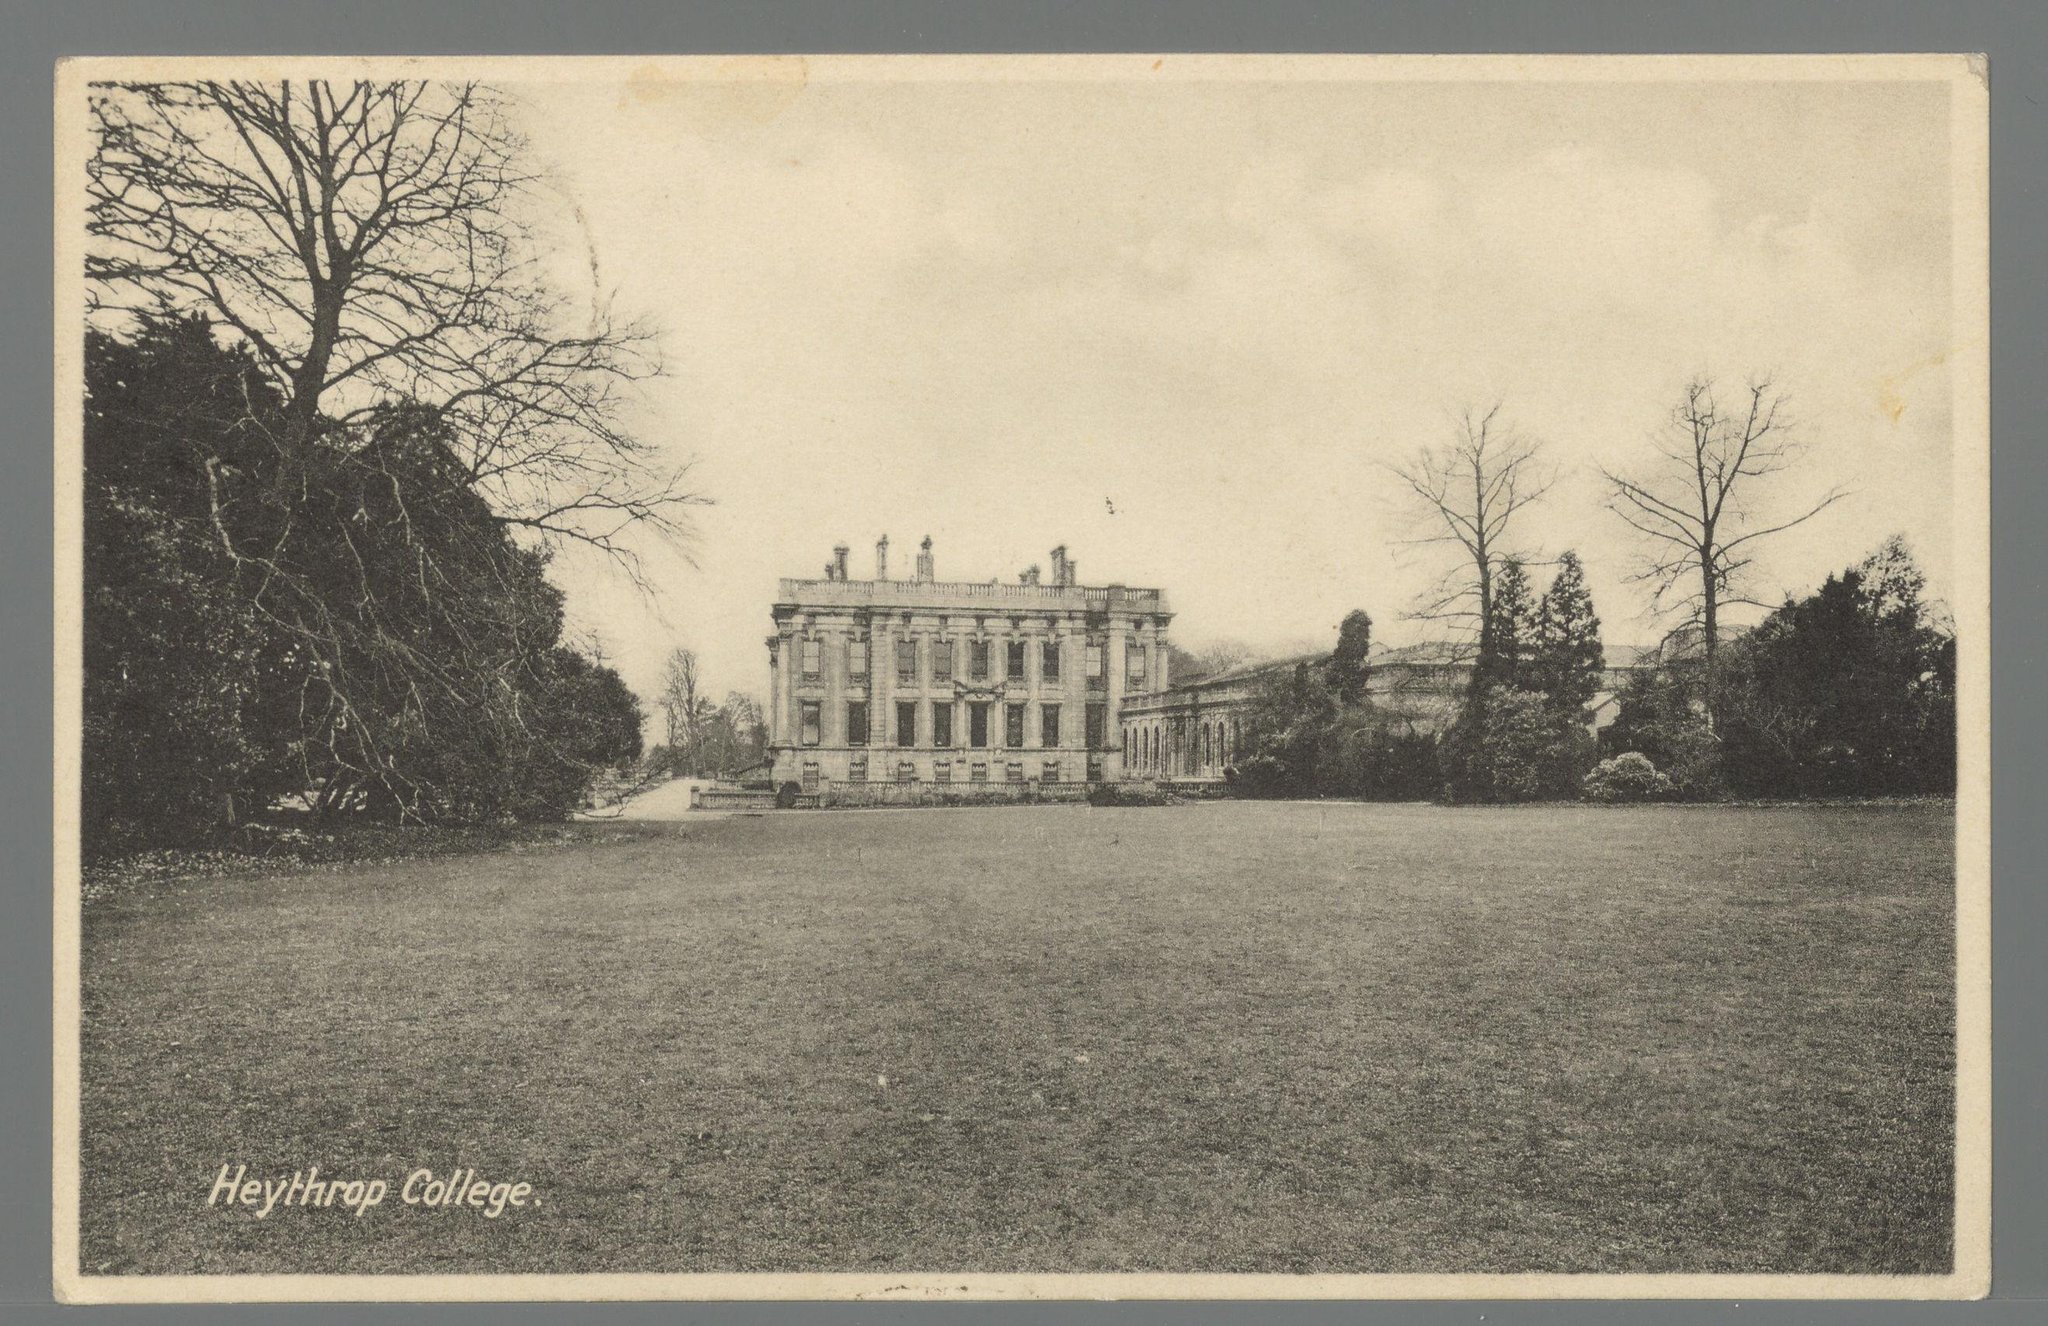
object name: photomechanical print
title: Heythrop College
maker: Anonymous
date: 1915-1930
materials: cardboard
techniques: photograph, writing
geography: heythrop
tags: university building, college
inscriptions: poststempel, verso, gestempeld